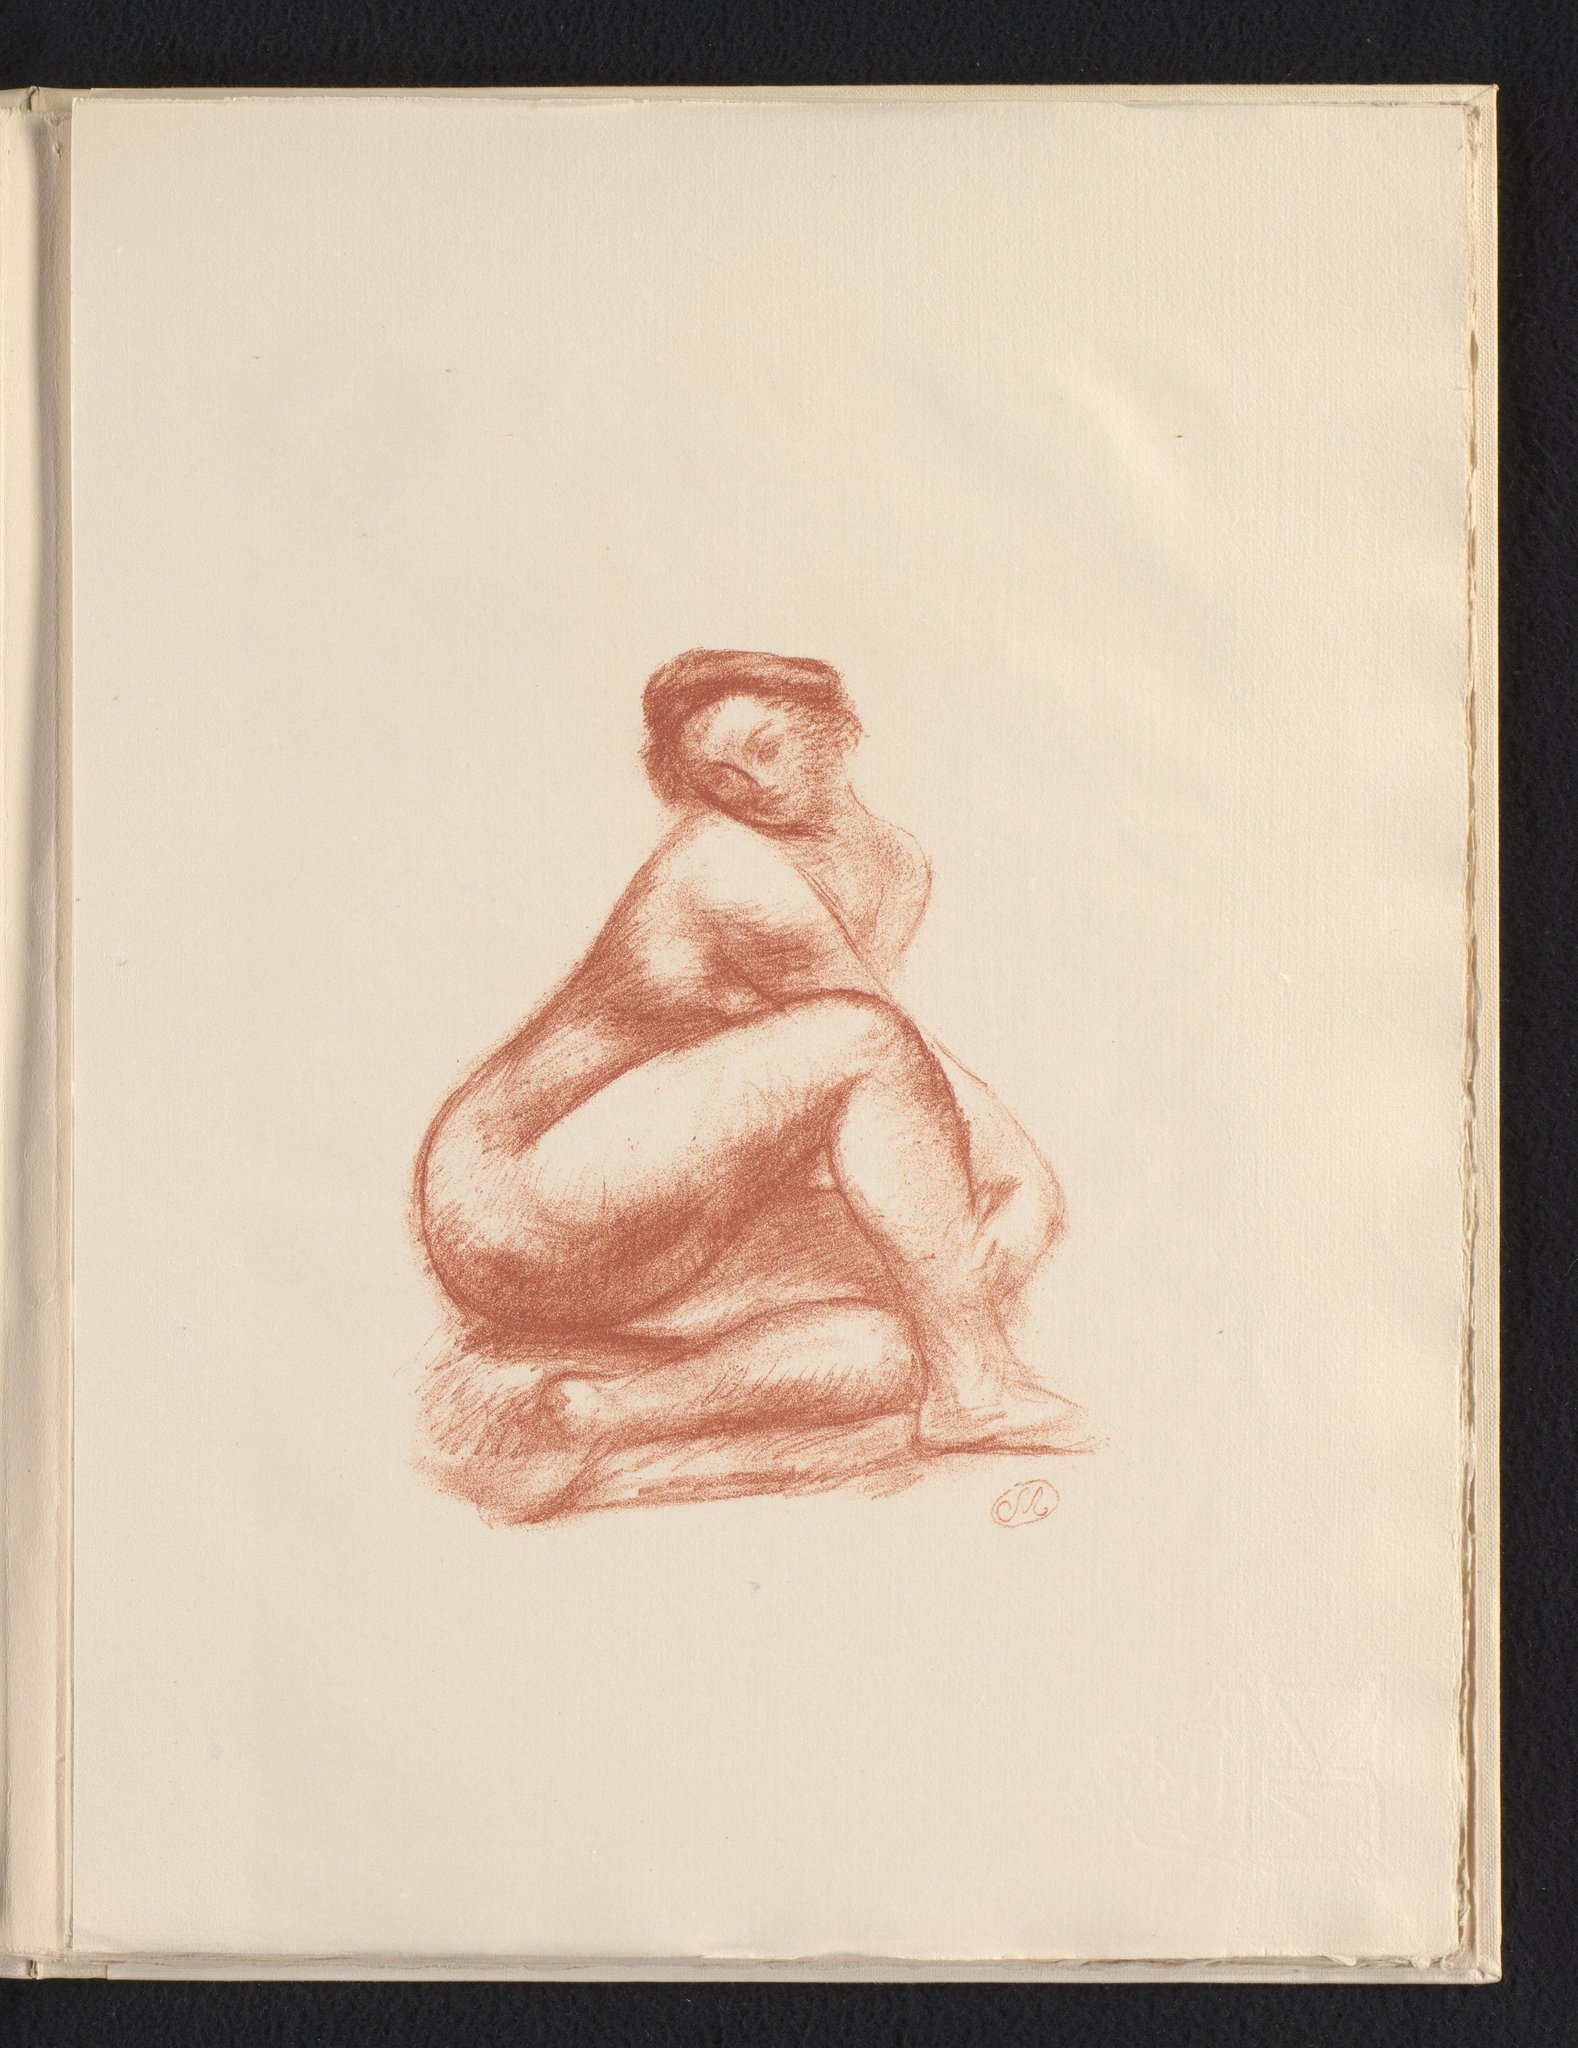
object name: print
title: Zittende naakte vrouw, over haar schouder kijkend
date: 1948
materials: paper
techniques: lithograph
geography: paris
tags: sitting figure - aa - female human figure, woman (showing herself) undressed, quasi-nude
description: Prent uit: Lucianus van Samosata. Dialogues des Courtisanes. [Vertaald uit het Grieks door] Charles Astruc. Parijs: s.n., 1948, deel van de suite met een extra afdruk van de prenten in sanguine.